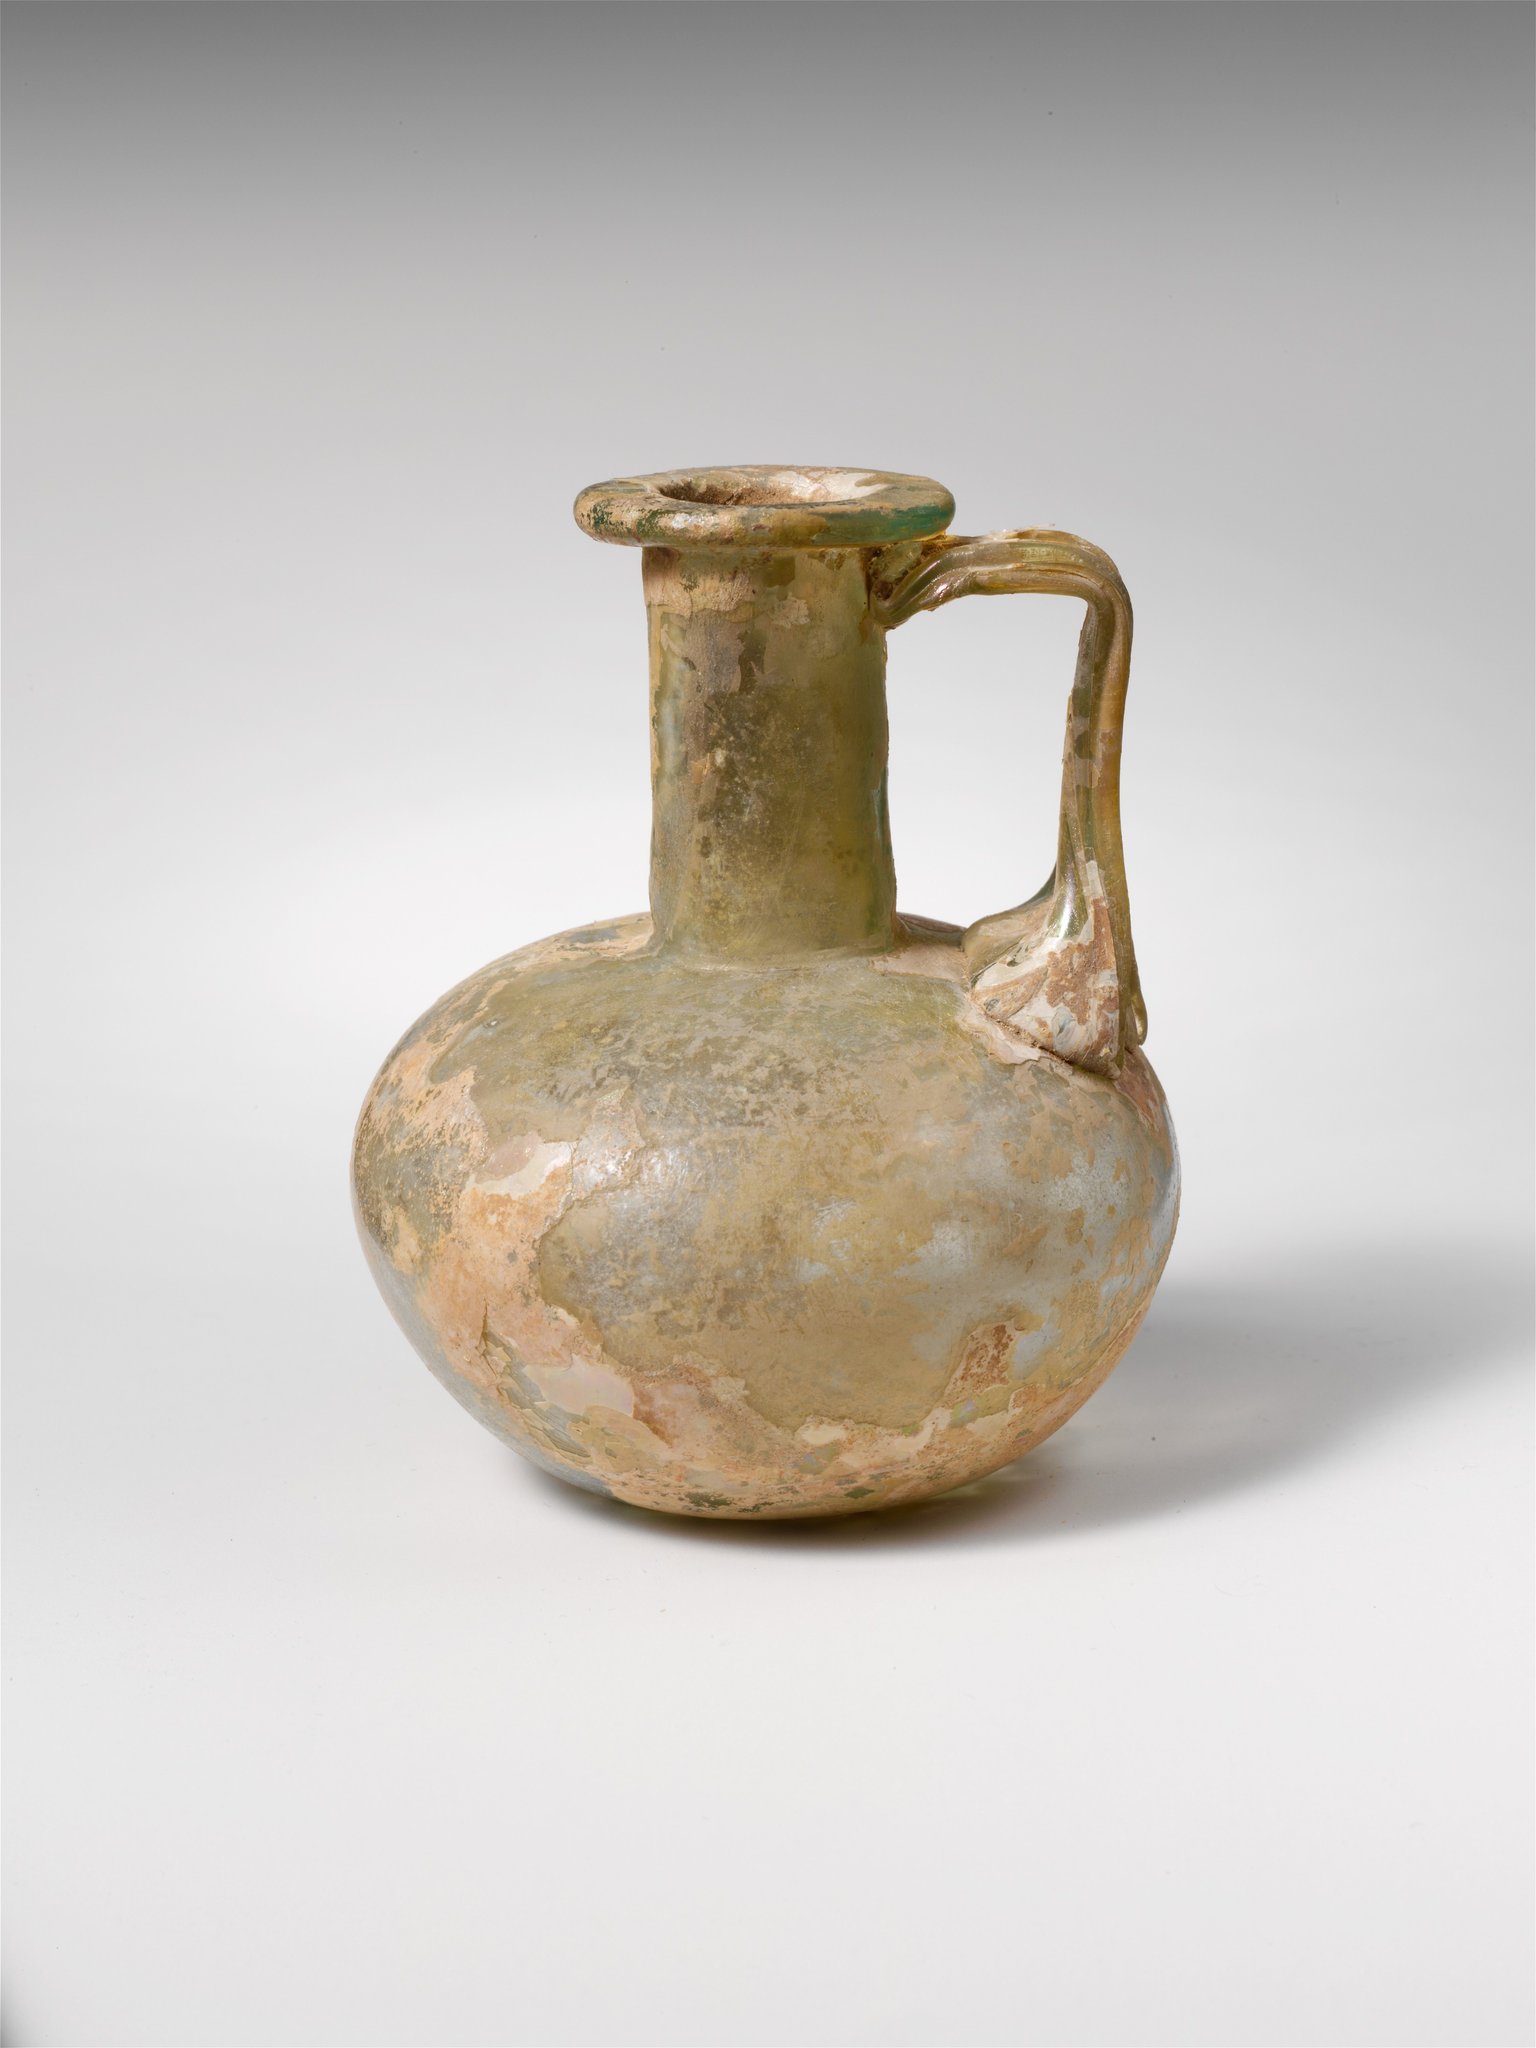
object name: jug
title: Glass jug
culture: roman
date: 1-200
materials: glass